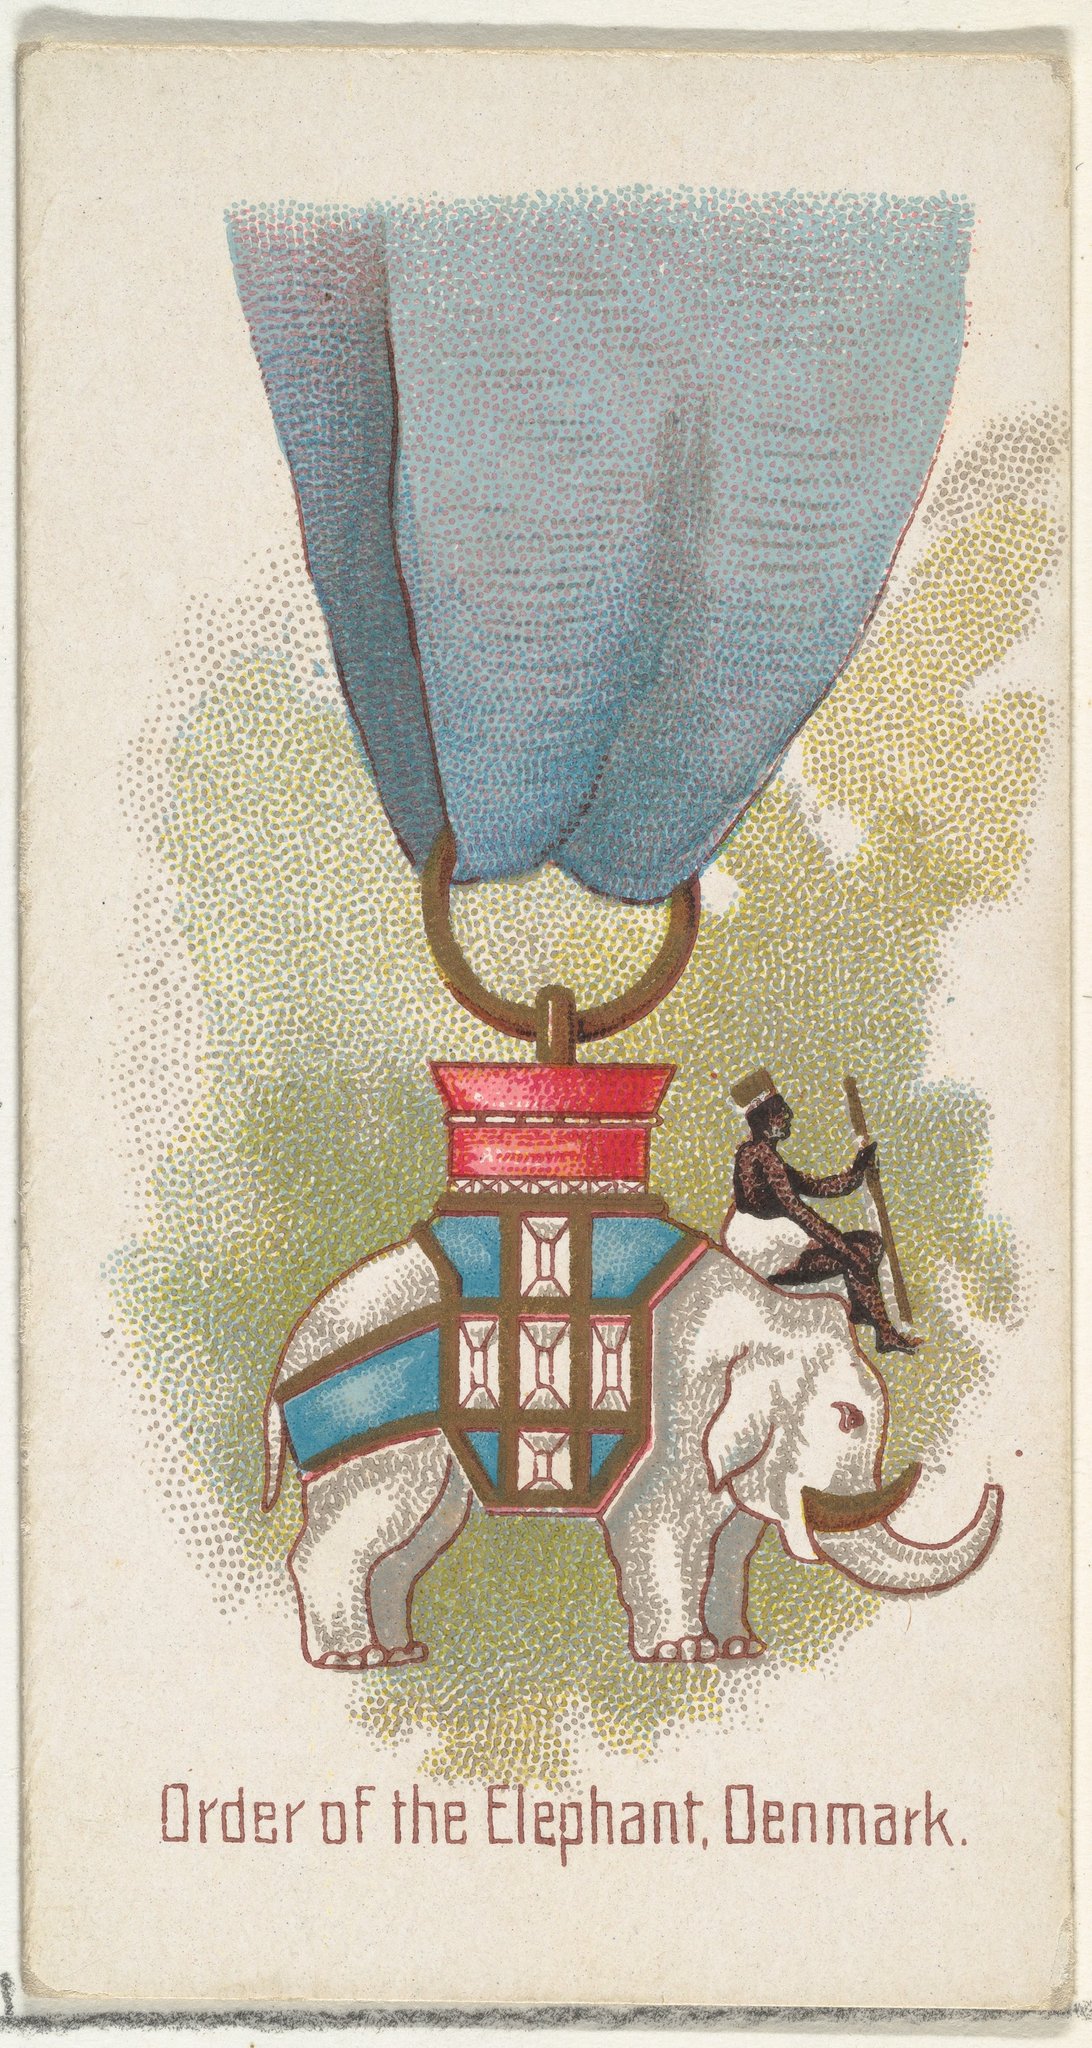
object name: print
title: Order of the Elephant, Denmark, from the World's Decorations series (N30) for Allen & Ginter Cigarettes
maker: allen & ginter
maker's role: publisher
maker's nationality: american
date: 1890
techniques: color lithograph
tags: elephants,medals